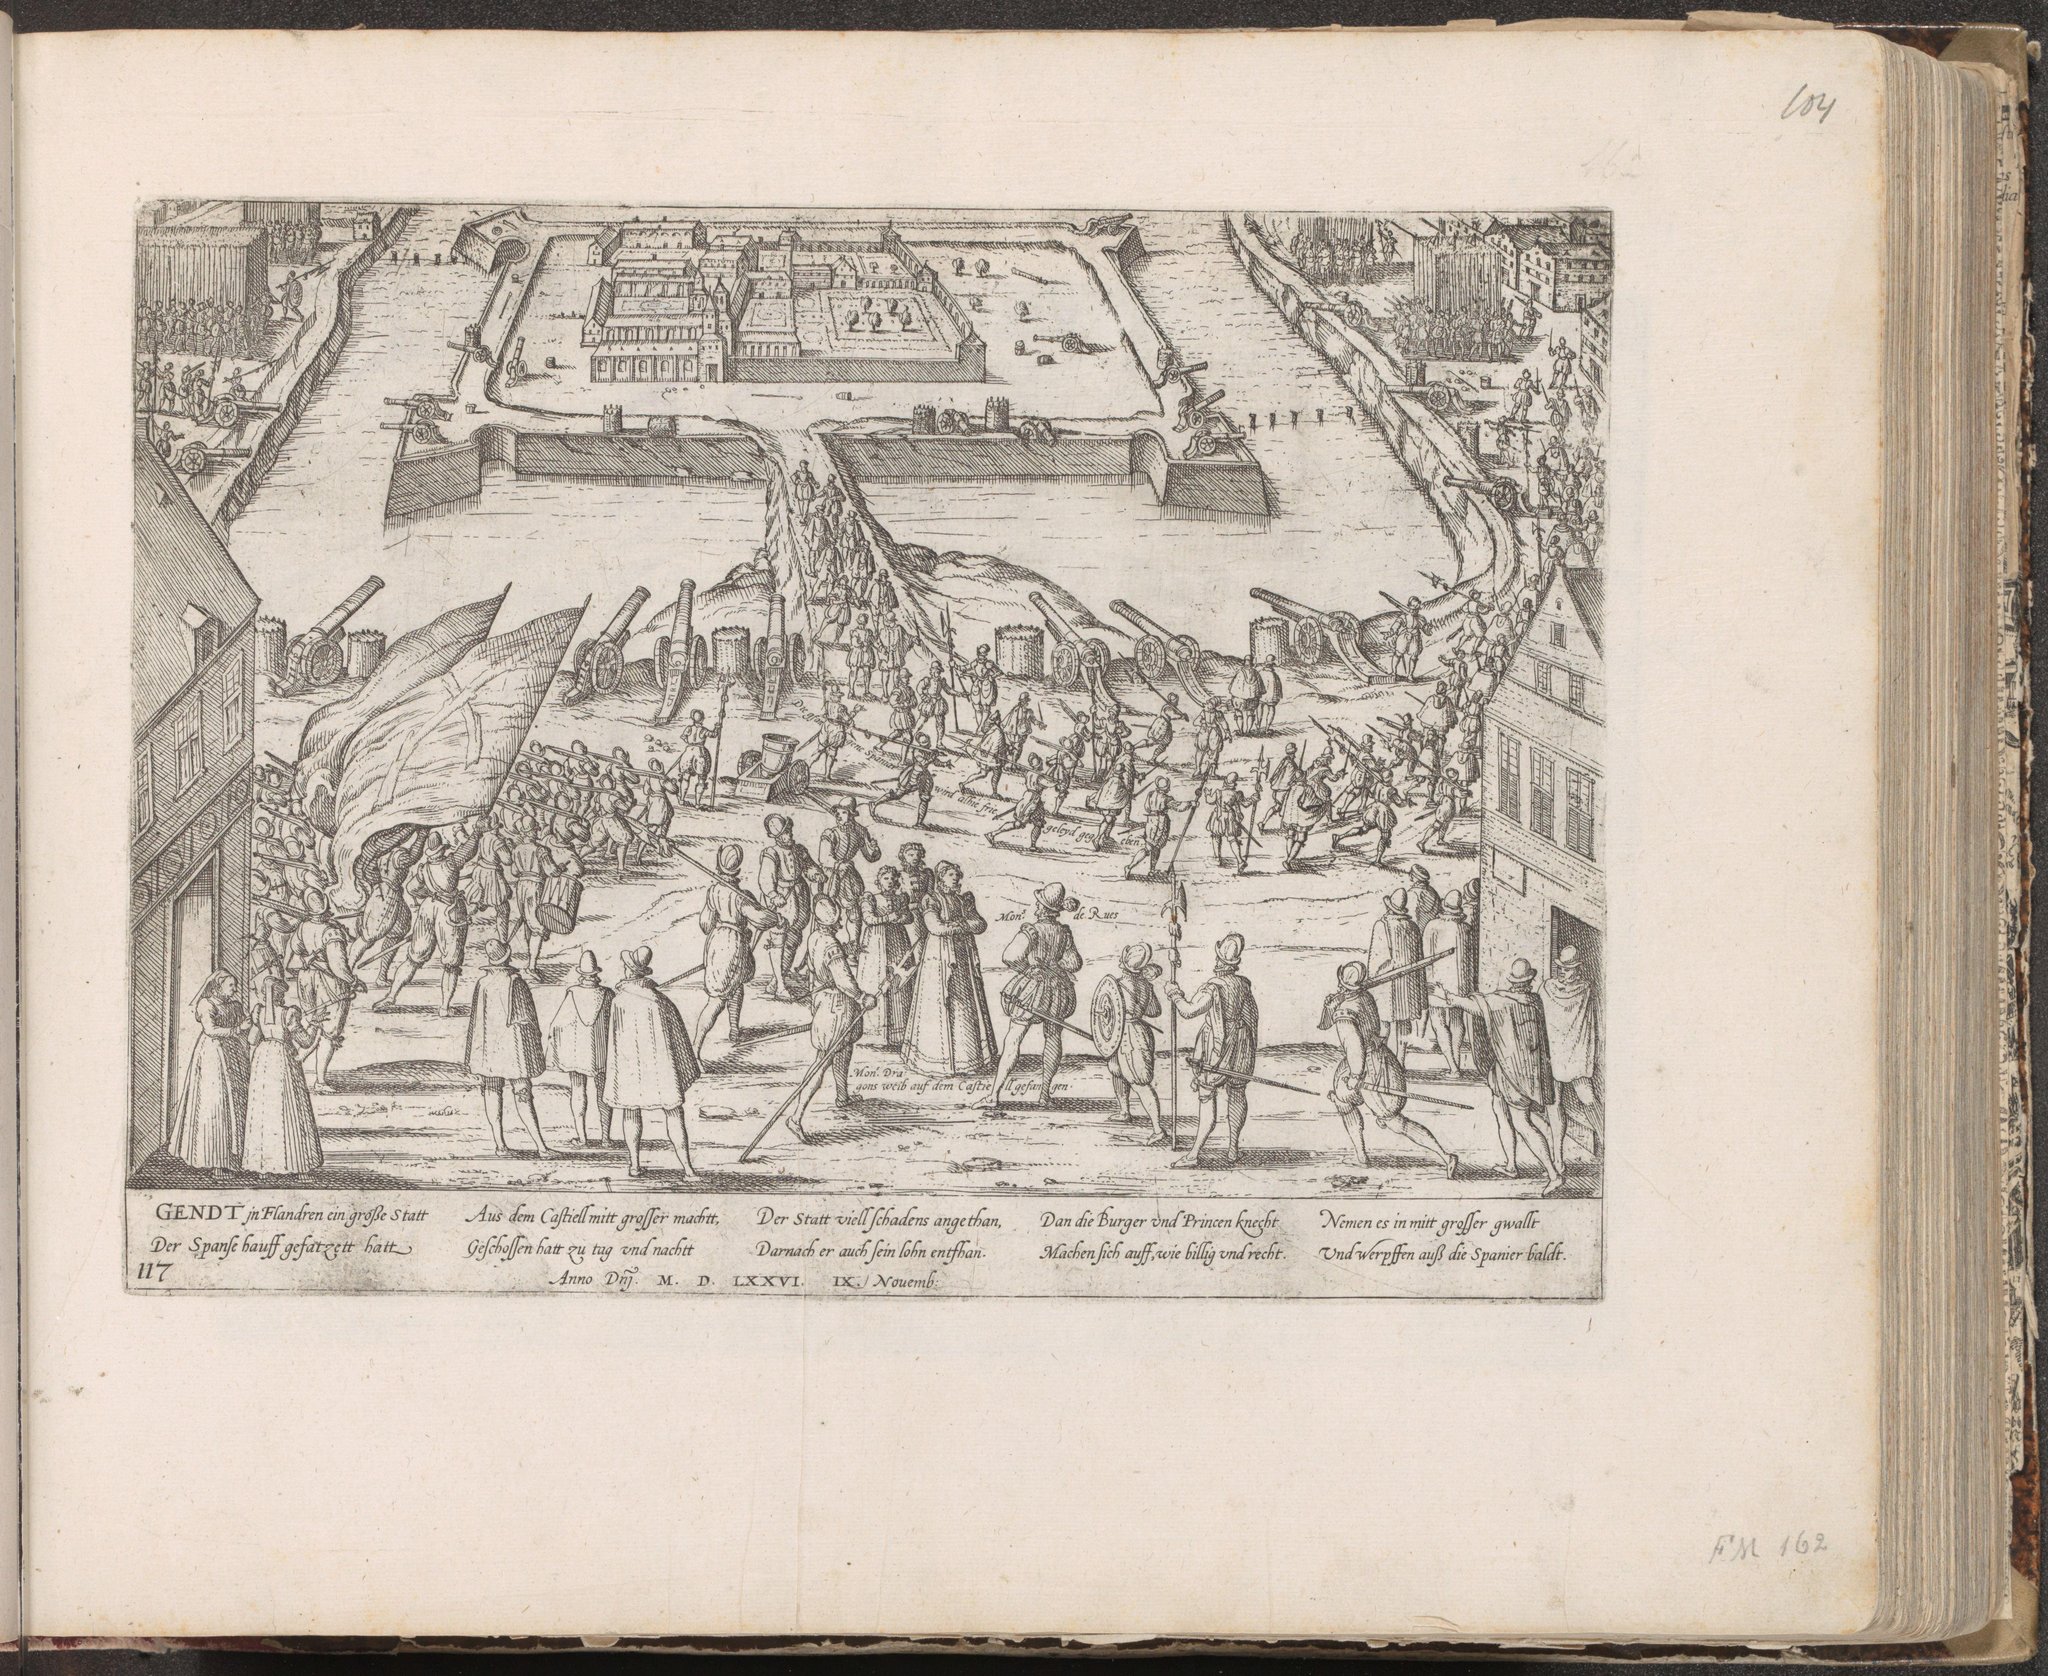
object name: history print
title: Aftocht van de Spanjaarden uit Gent, 1576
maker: frans hogenberg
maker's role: print maker, publisher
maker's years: 1538-1590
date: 1576-1579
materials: paper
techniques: etching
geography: cologne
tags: antwerp, capture of city (after the siege), ghent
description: Aftocht van de Spanjaarden onder vrijgeleide uit de citadel van Gent na beleg door het Staatse leger, 9 november 1576. Op de voorgrond de vrouw van de Spaanse legeraanvoerder Mondragon. Met onderschrift van 10 regels in het Duits. Linksonder genummerd: 117. De prent maakt deel uit van een album.